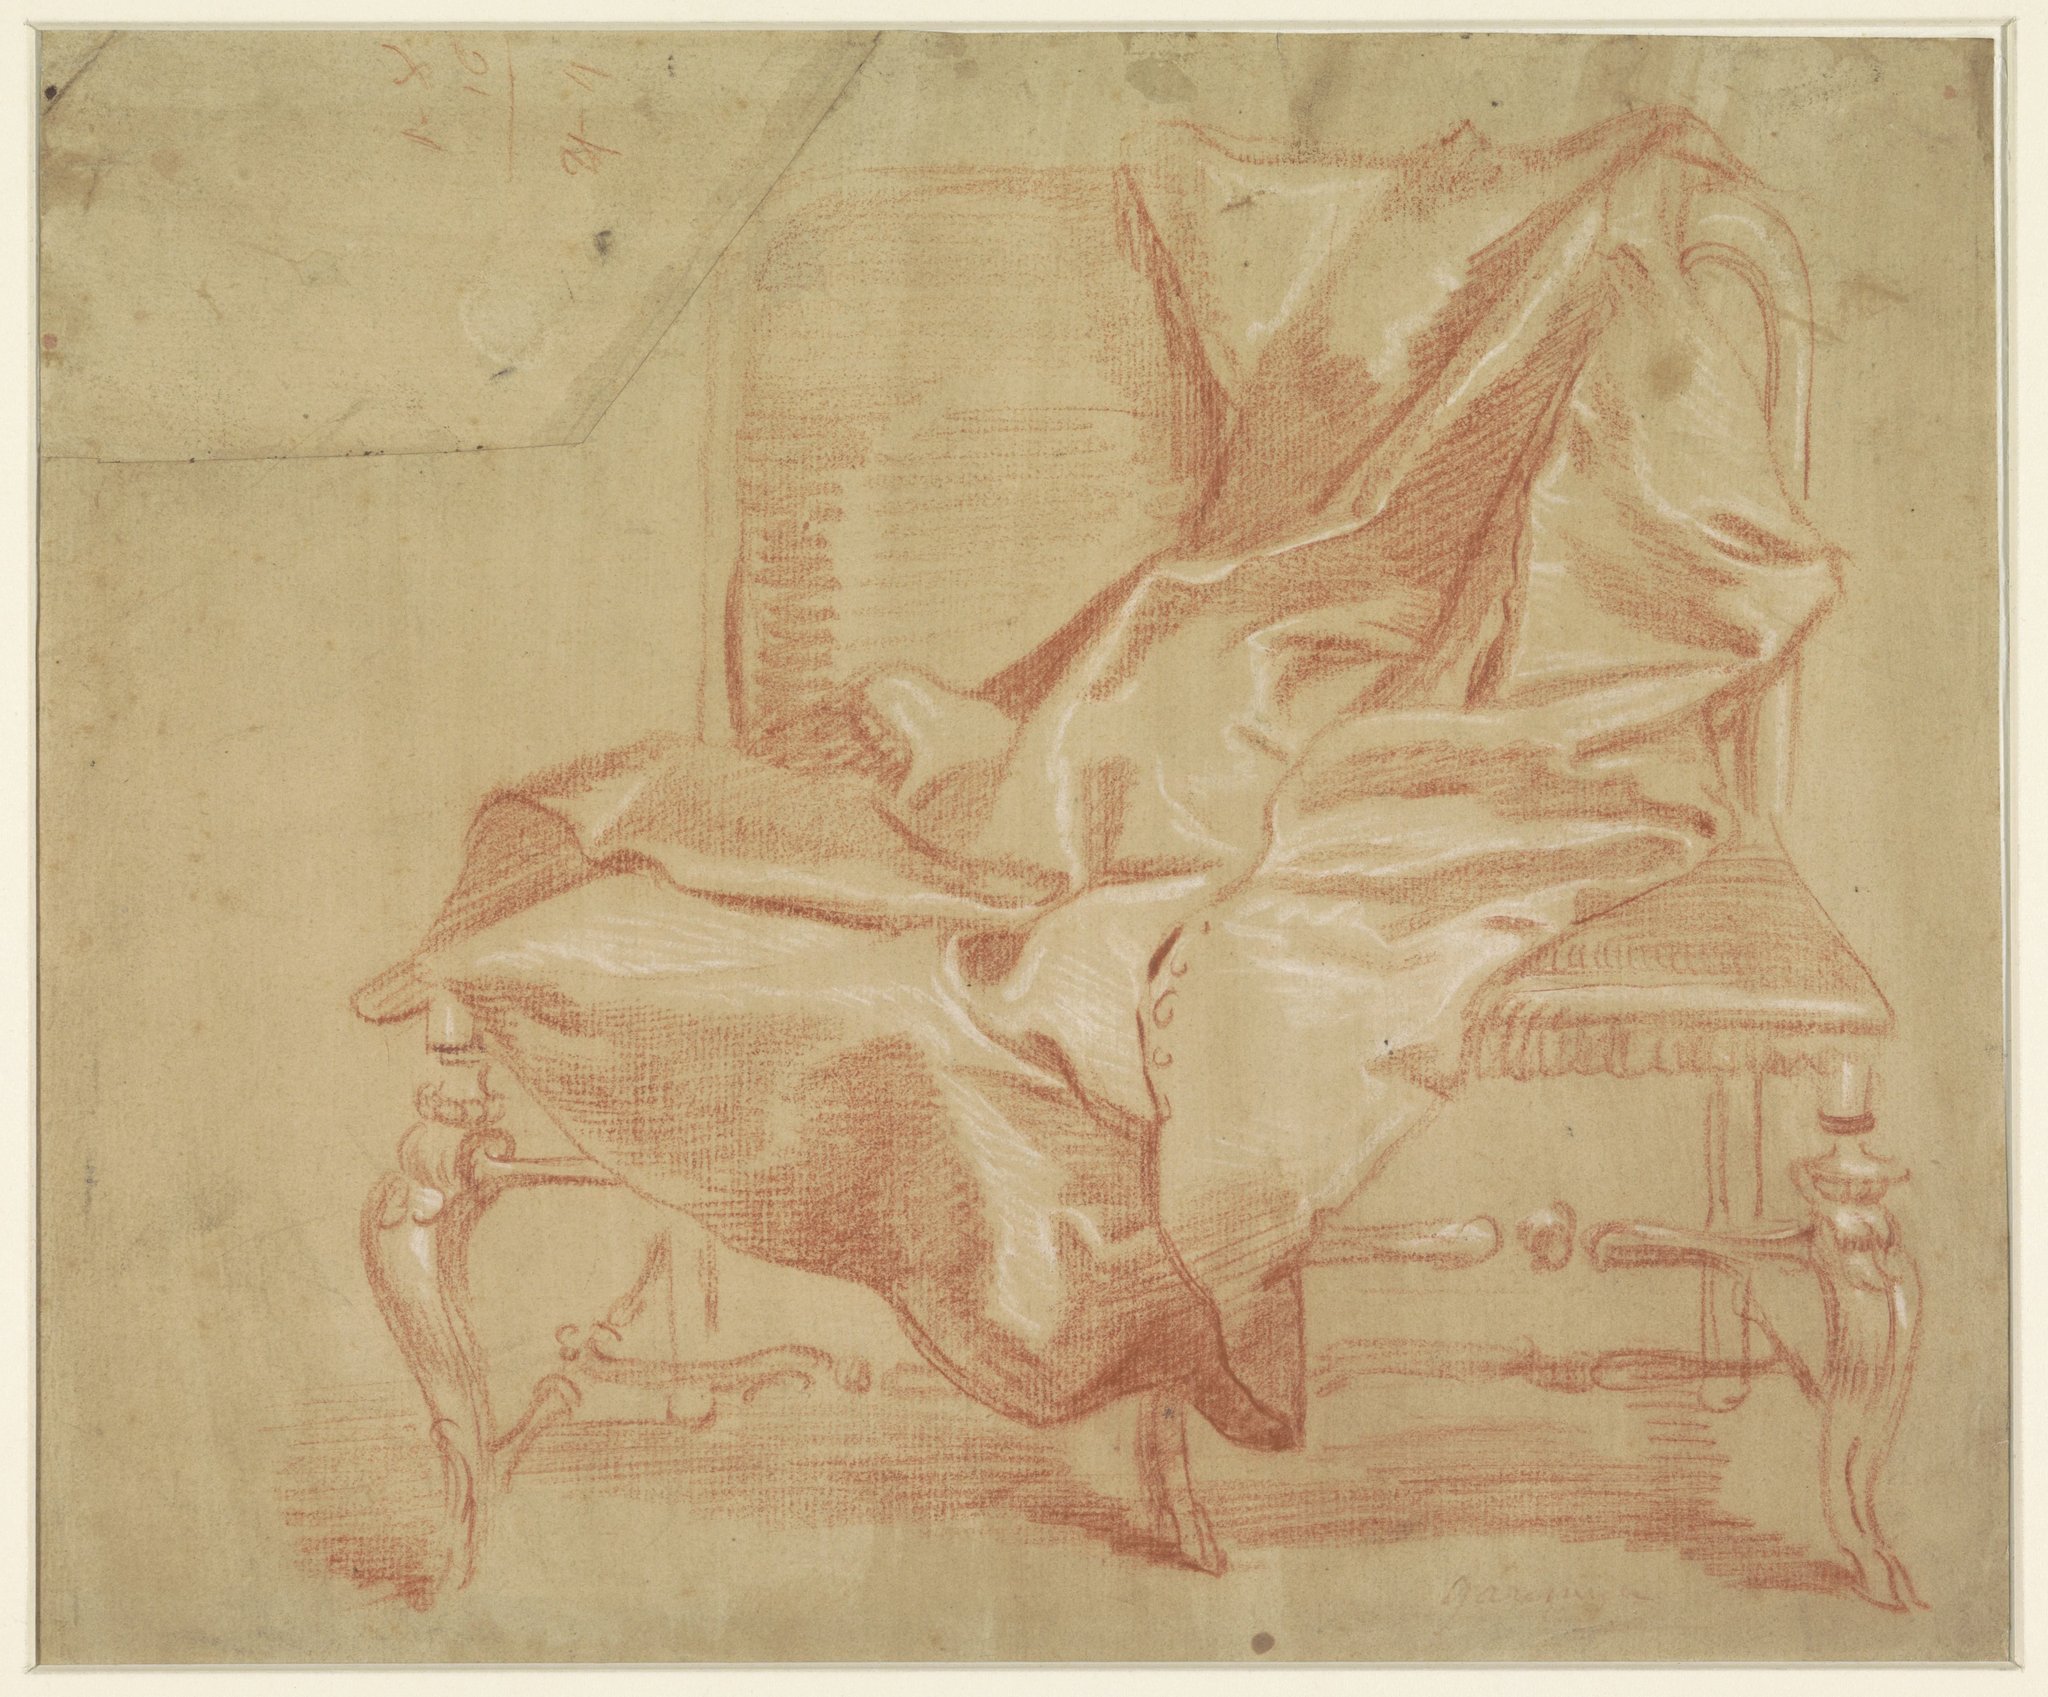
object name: drawing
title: Jas liggend op een dubbele leunstoel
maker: jan anton garemyn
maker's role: draughtsman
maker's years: 1712-1799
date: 1722-1799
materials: chalk, paper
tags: armchair, seat, coat (+ men's clothes), drapery, draped garment, 'gewandgebung'